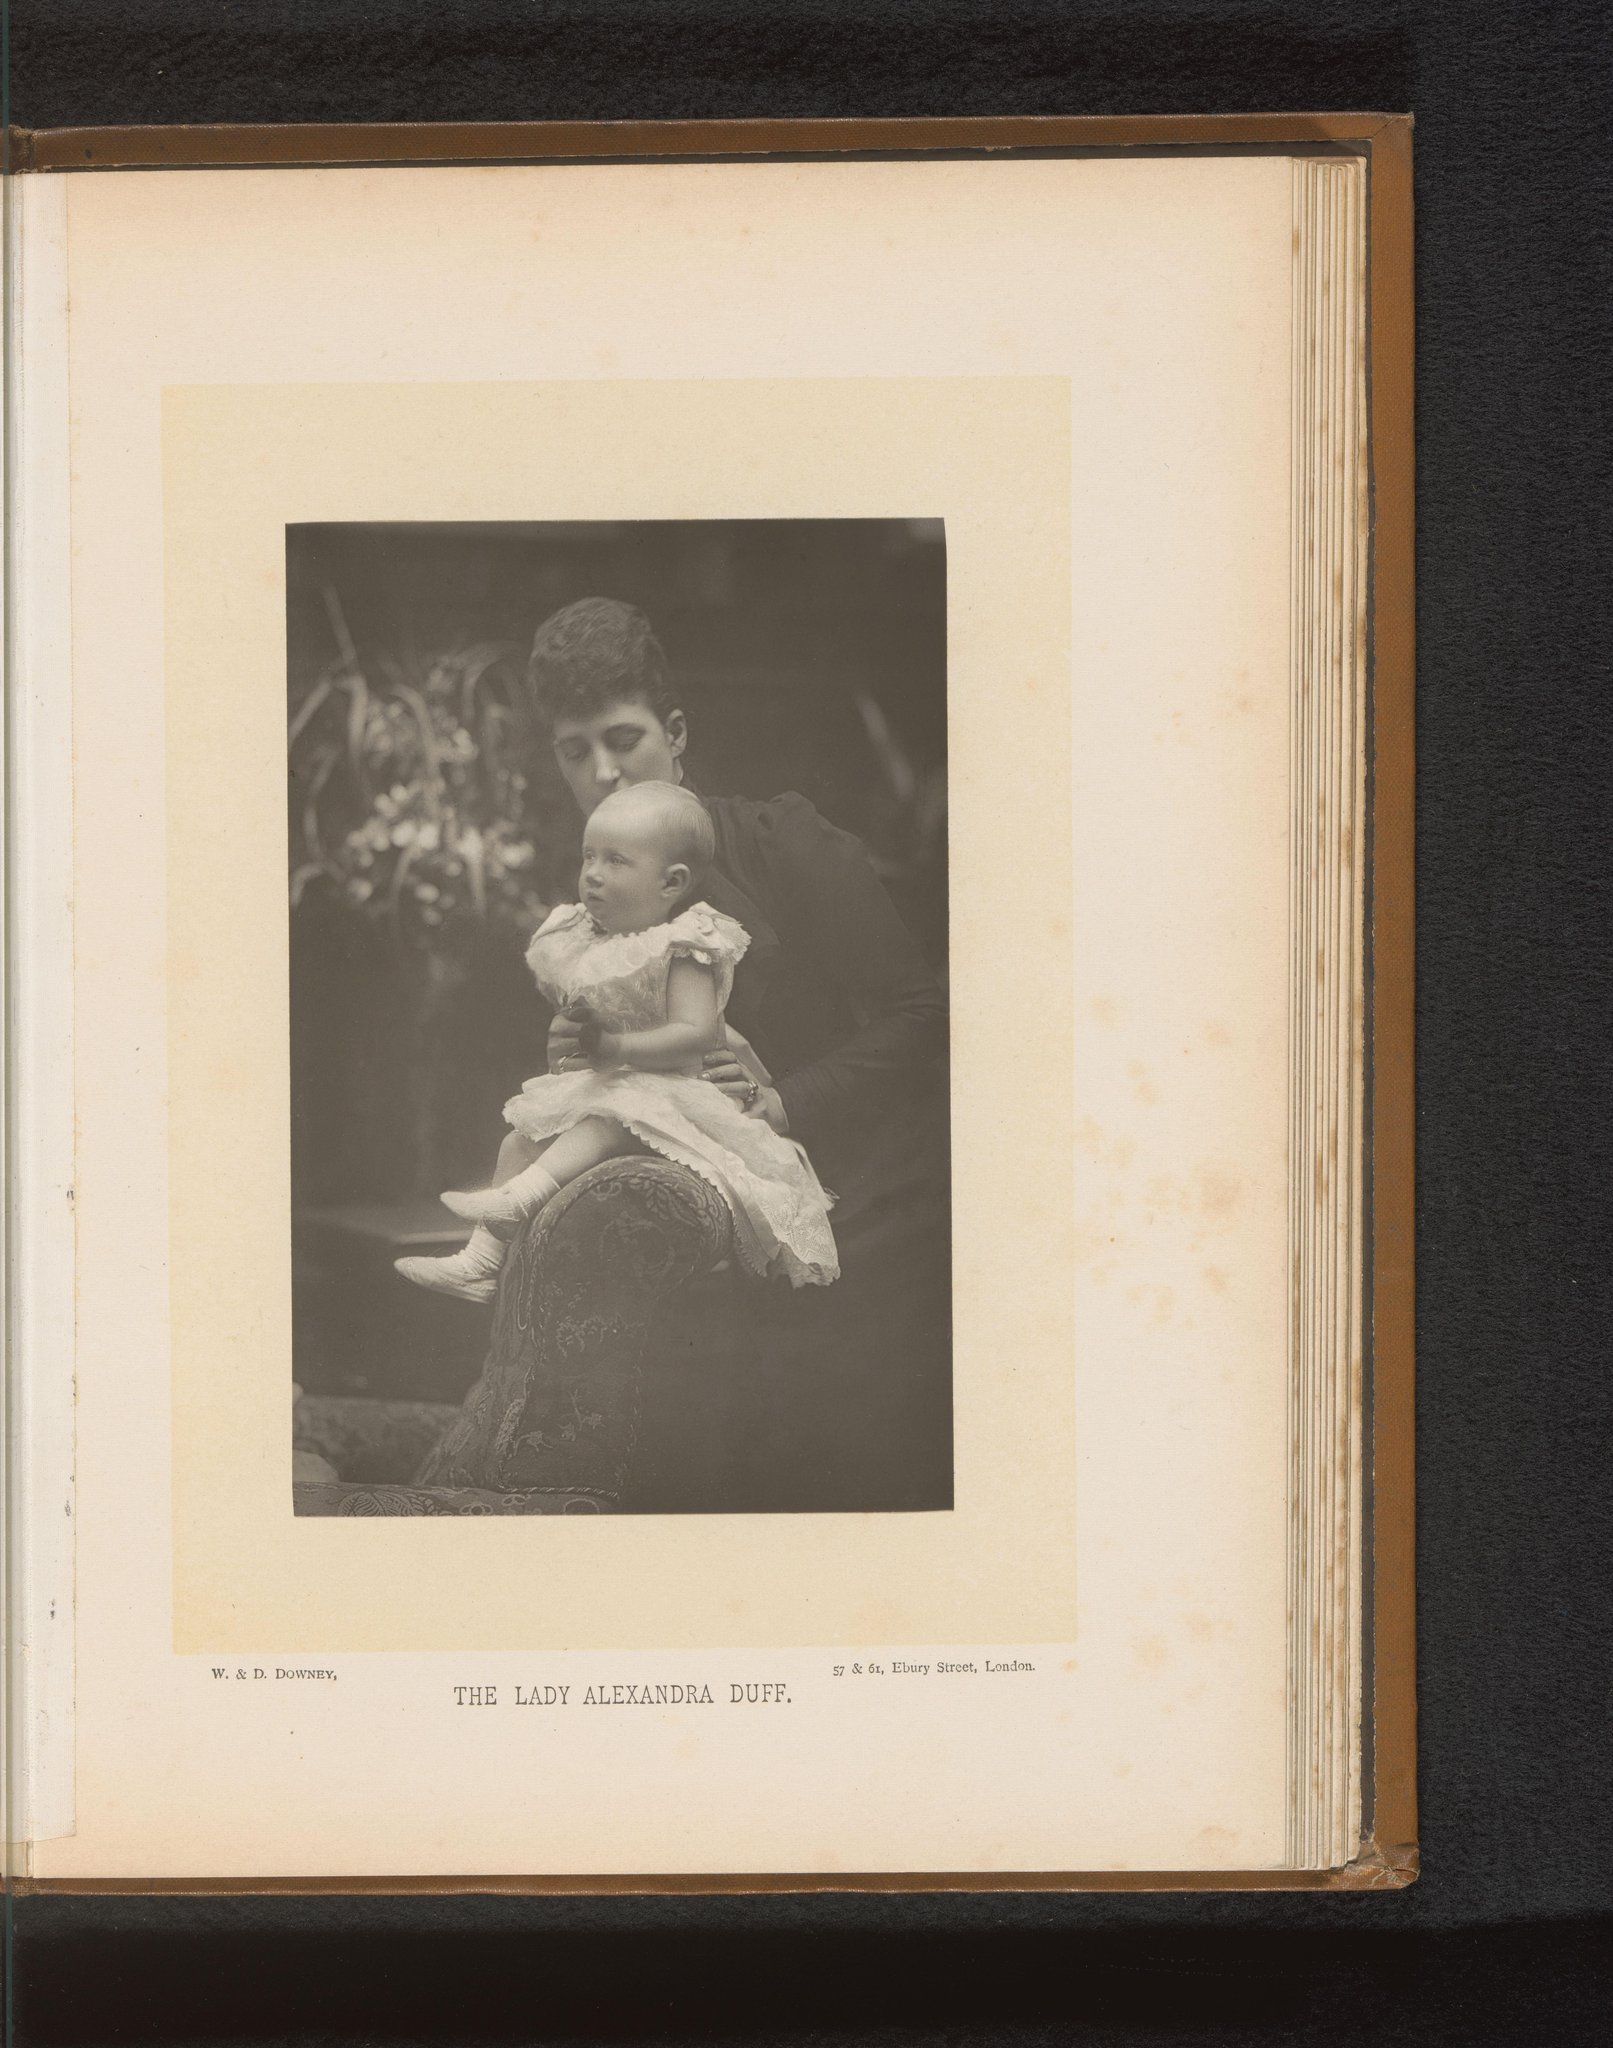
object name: photomechanical print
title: The Lady Alexandra Duff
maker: Anonymous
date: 1883-1893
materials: paper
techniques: woodburytype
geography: london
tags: ruler, sovereign - bb - female ruler, mother and baby or young child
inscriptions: inscription: ‘57 & 61, Elbury Street, London.’